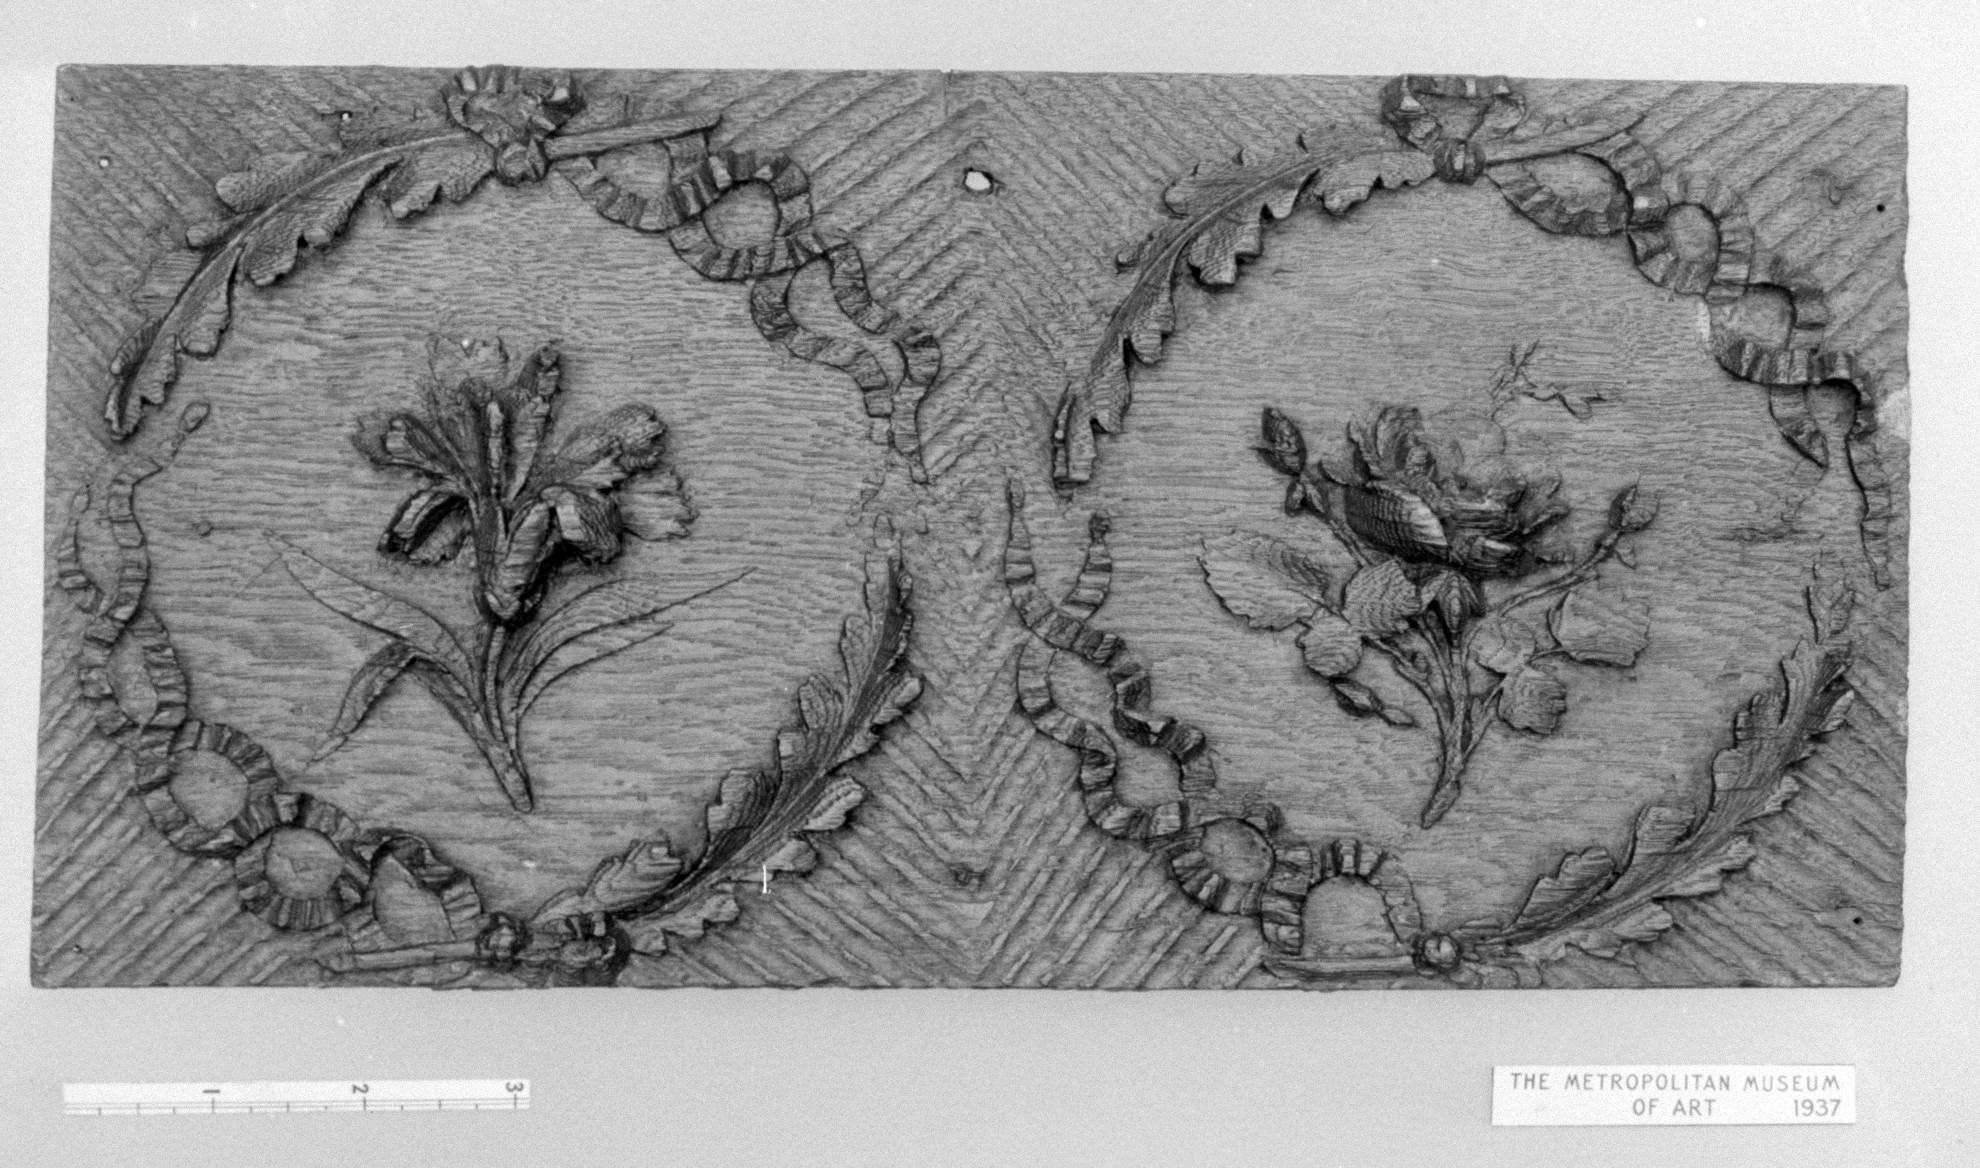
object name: panel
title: Panel (part of a set)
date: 1701-1800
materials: wood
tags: flowers,leaves